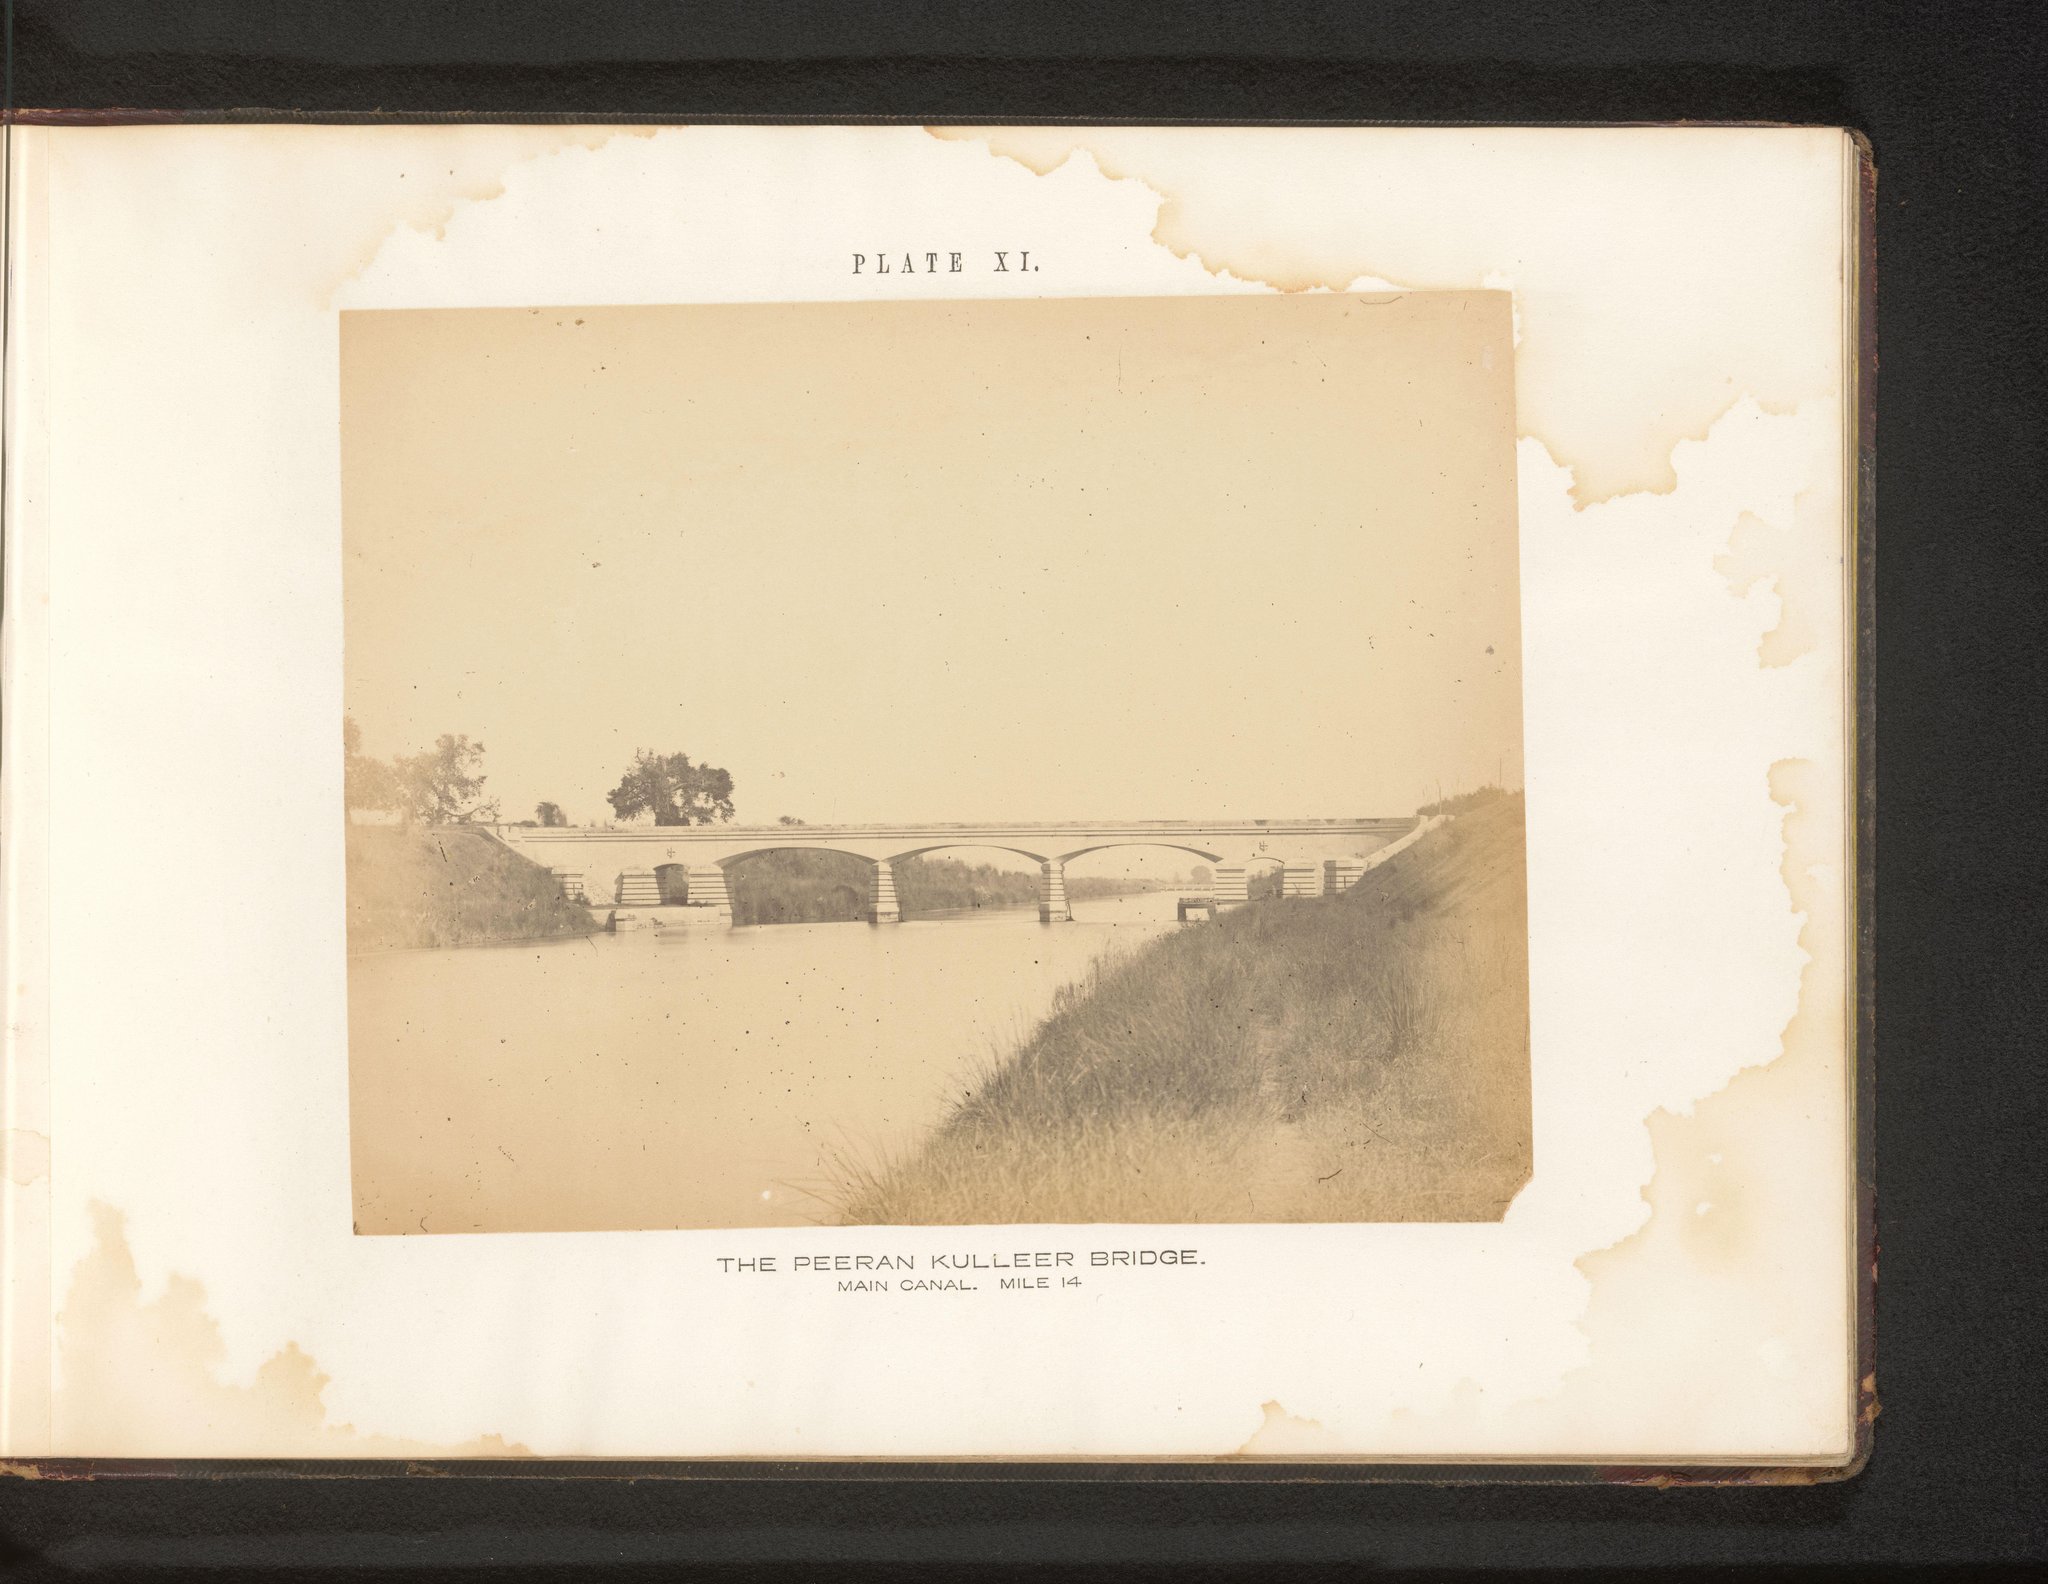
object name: photograph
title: Gezicht op een brug over de Ganges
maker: thomas george glover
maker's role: fotograaf, luitenant-kolonel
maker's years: 1825-1881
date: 1862-1867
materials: photographic support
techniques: albumen print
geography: india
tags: river, bridge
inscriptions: inscription: ‘Plate XI’, inscription: ‘main canal. mile 14.’